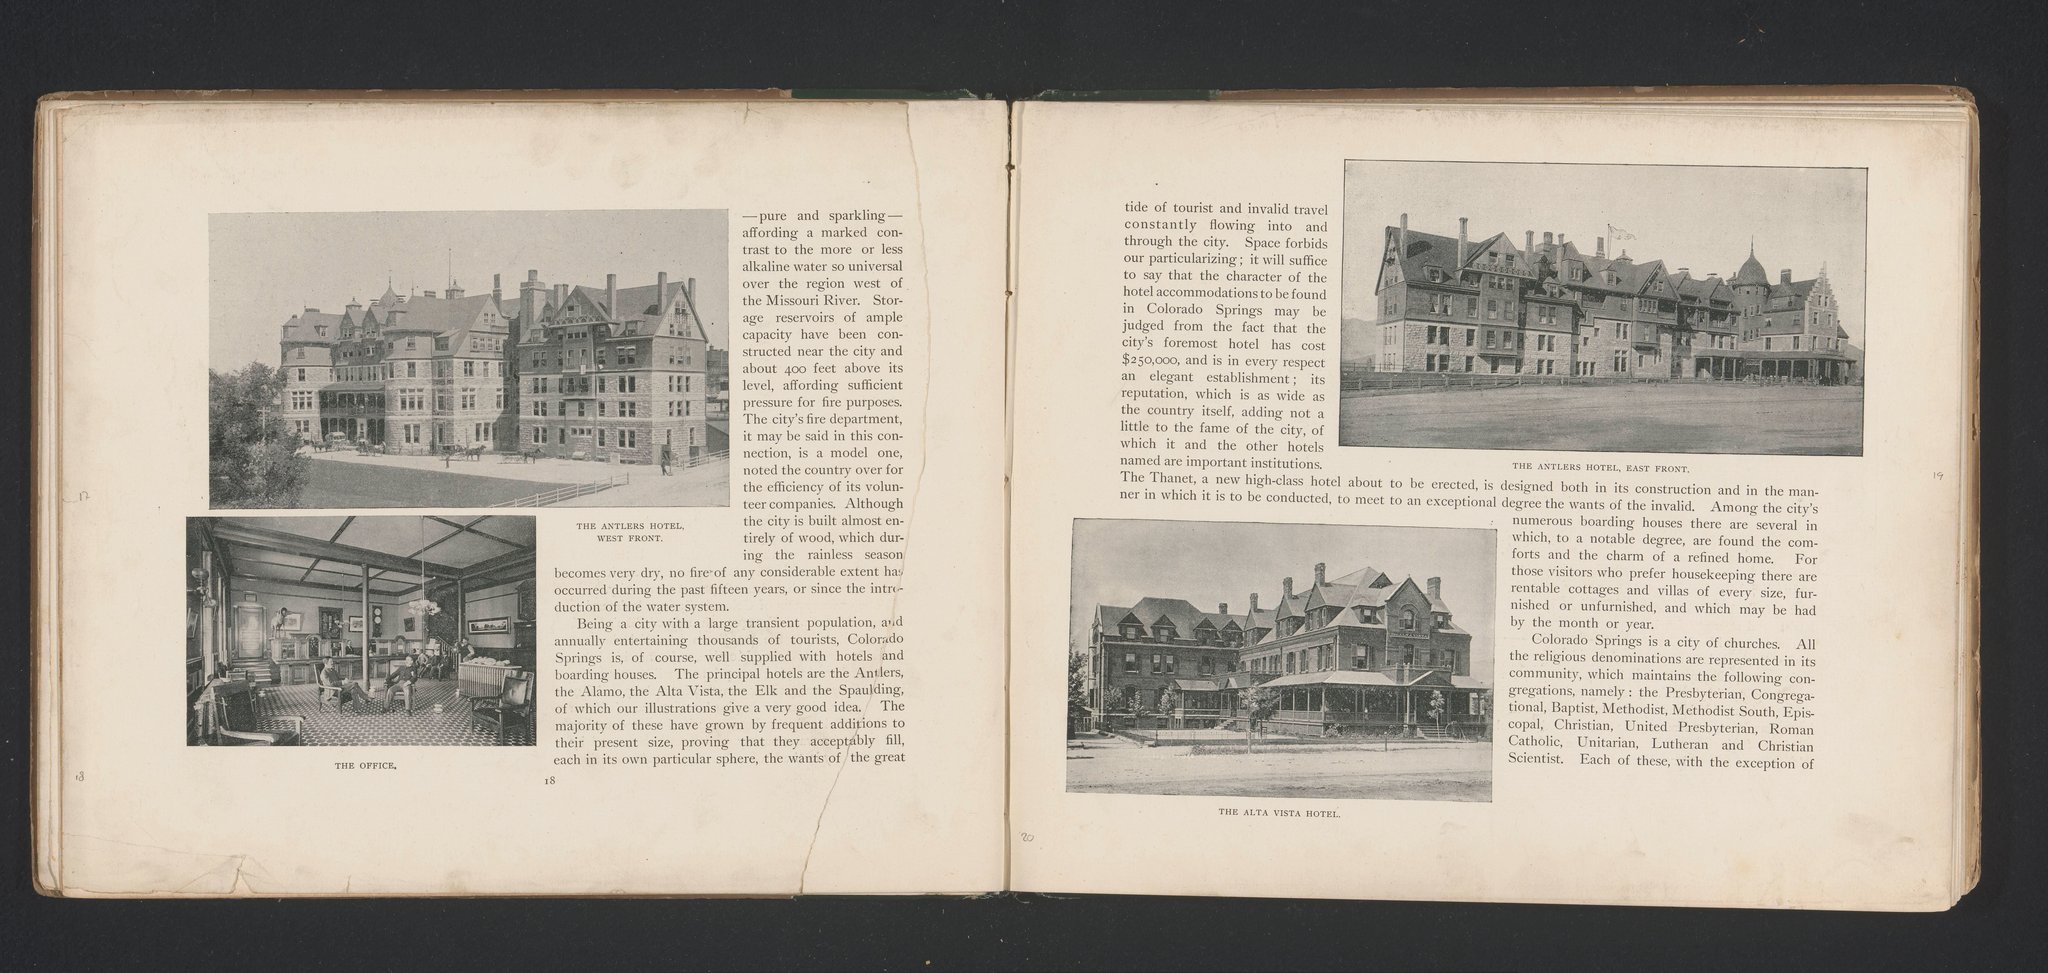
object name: photomechanical print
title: The office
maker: Anonymous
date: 1888-1893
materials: paper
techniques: autotype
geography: colorado springs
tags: historical persons, office (~ administration)